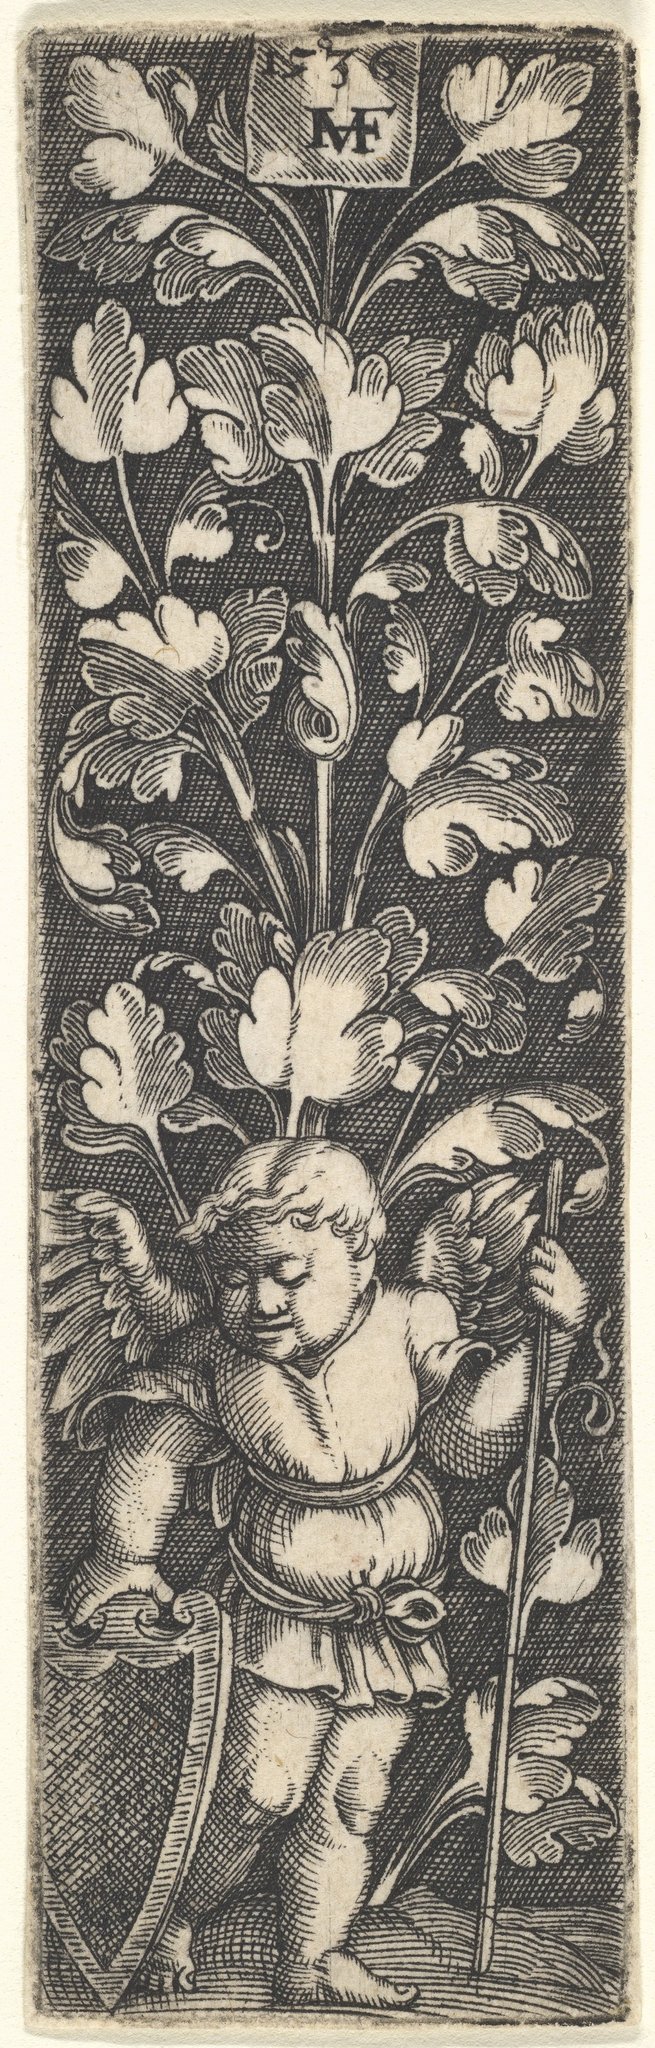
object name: print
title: Ornament with a Genius Holding a Shield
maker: master mvhf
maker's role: artist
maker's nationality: german (?)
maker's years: 1500-1550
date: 1536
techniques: engraving